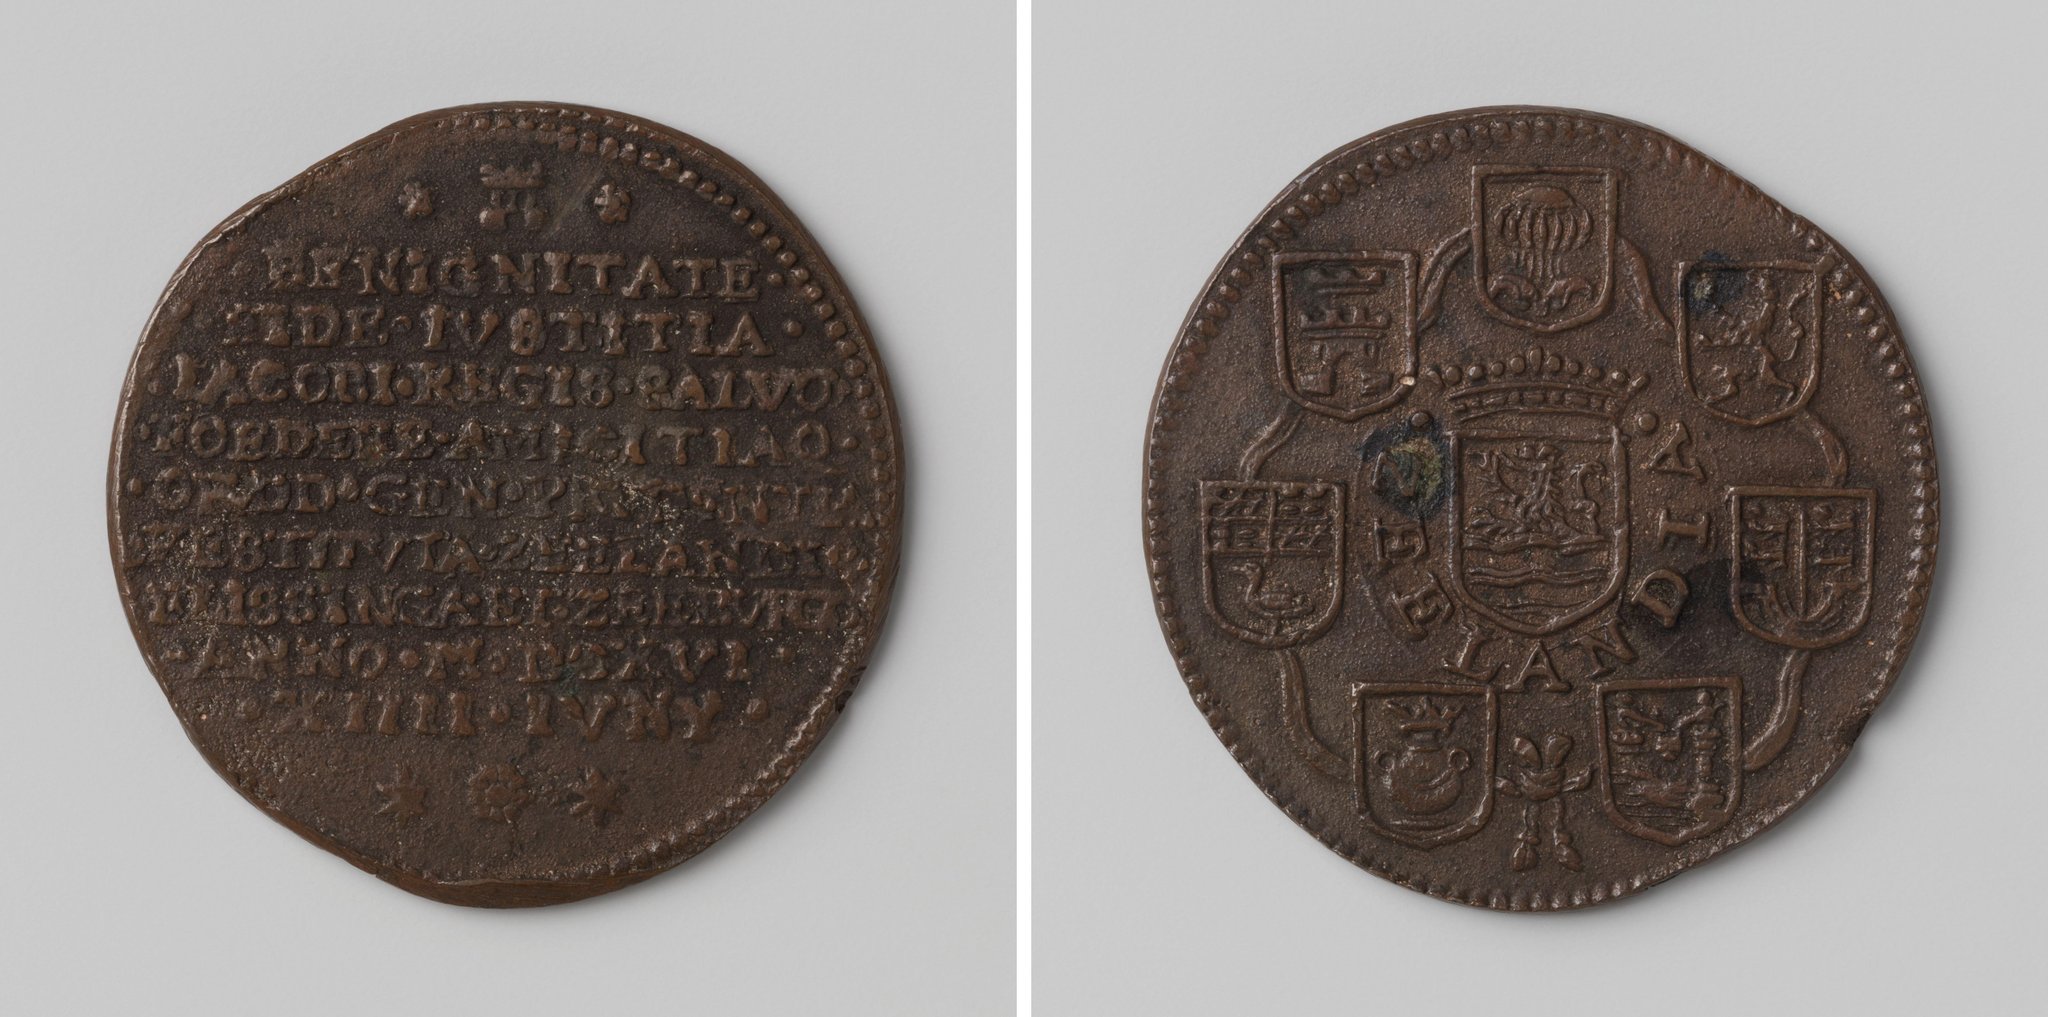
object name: history medal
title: Teruggave van de pandsteden Vlissingen en Zeeburg door de Engelsen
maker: Anonymous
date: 1616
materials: copper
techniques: striking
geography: middelburg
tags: jacobus i (koning van engeland), flushing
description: Koperen penning. Voorzijde: opschrift. Keerzijde: gekroond wapenschild binnen omschrift en rand van zeven met lint verbonden wapenschilden